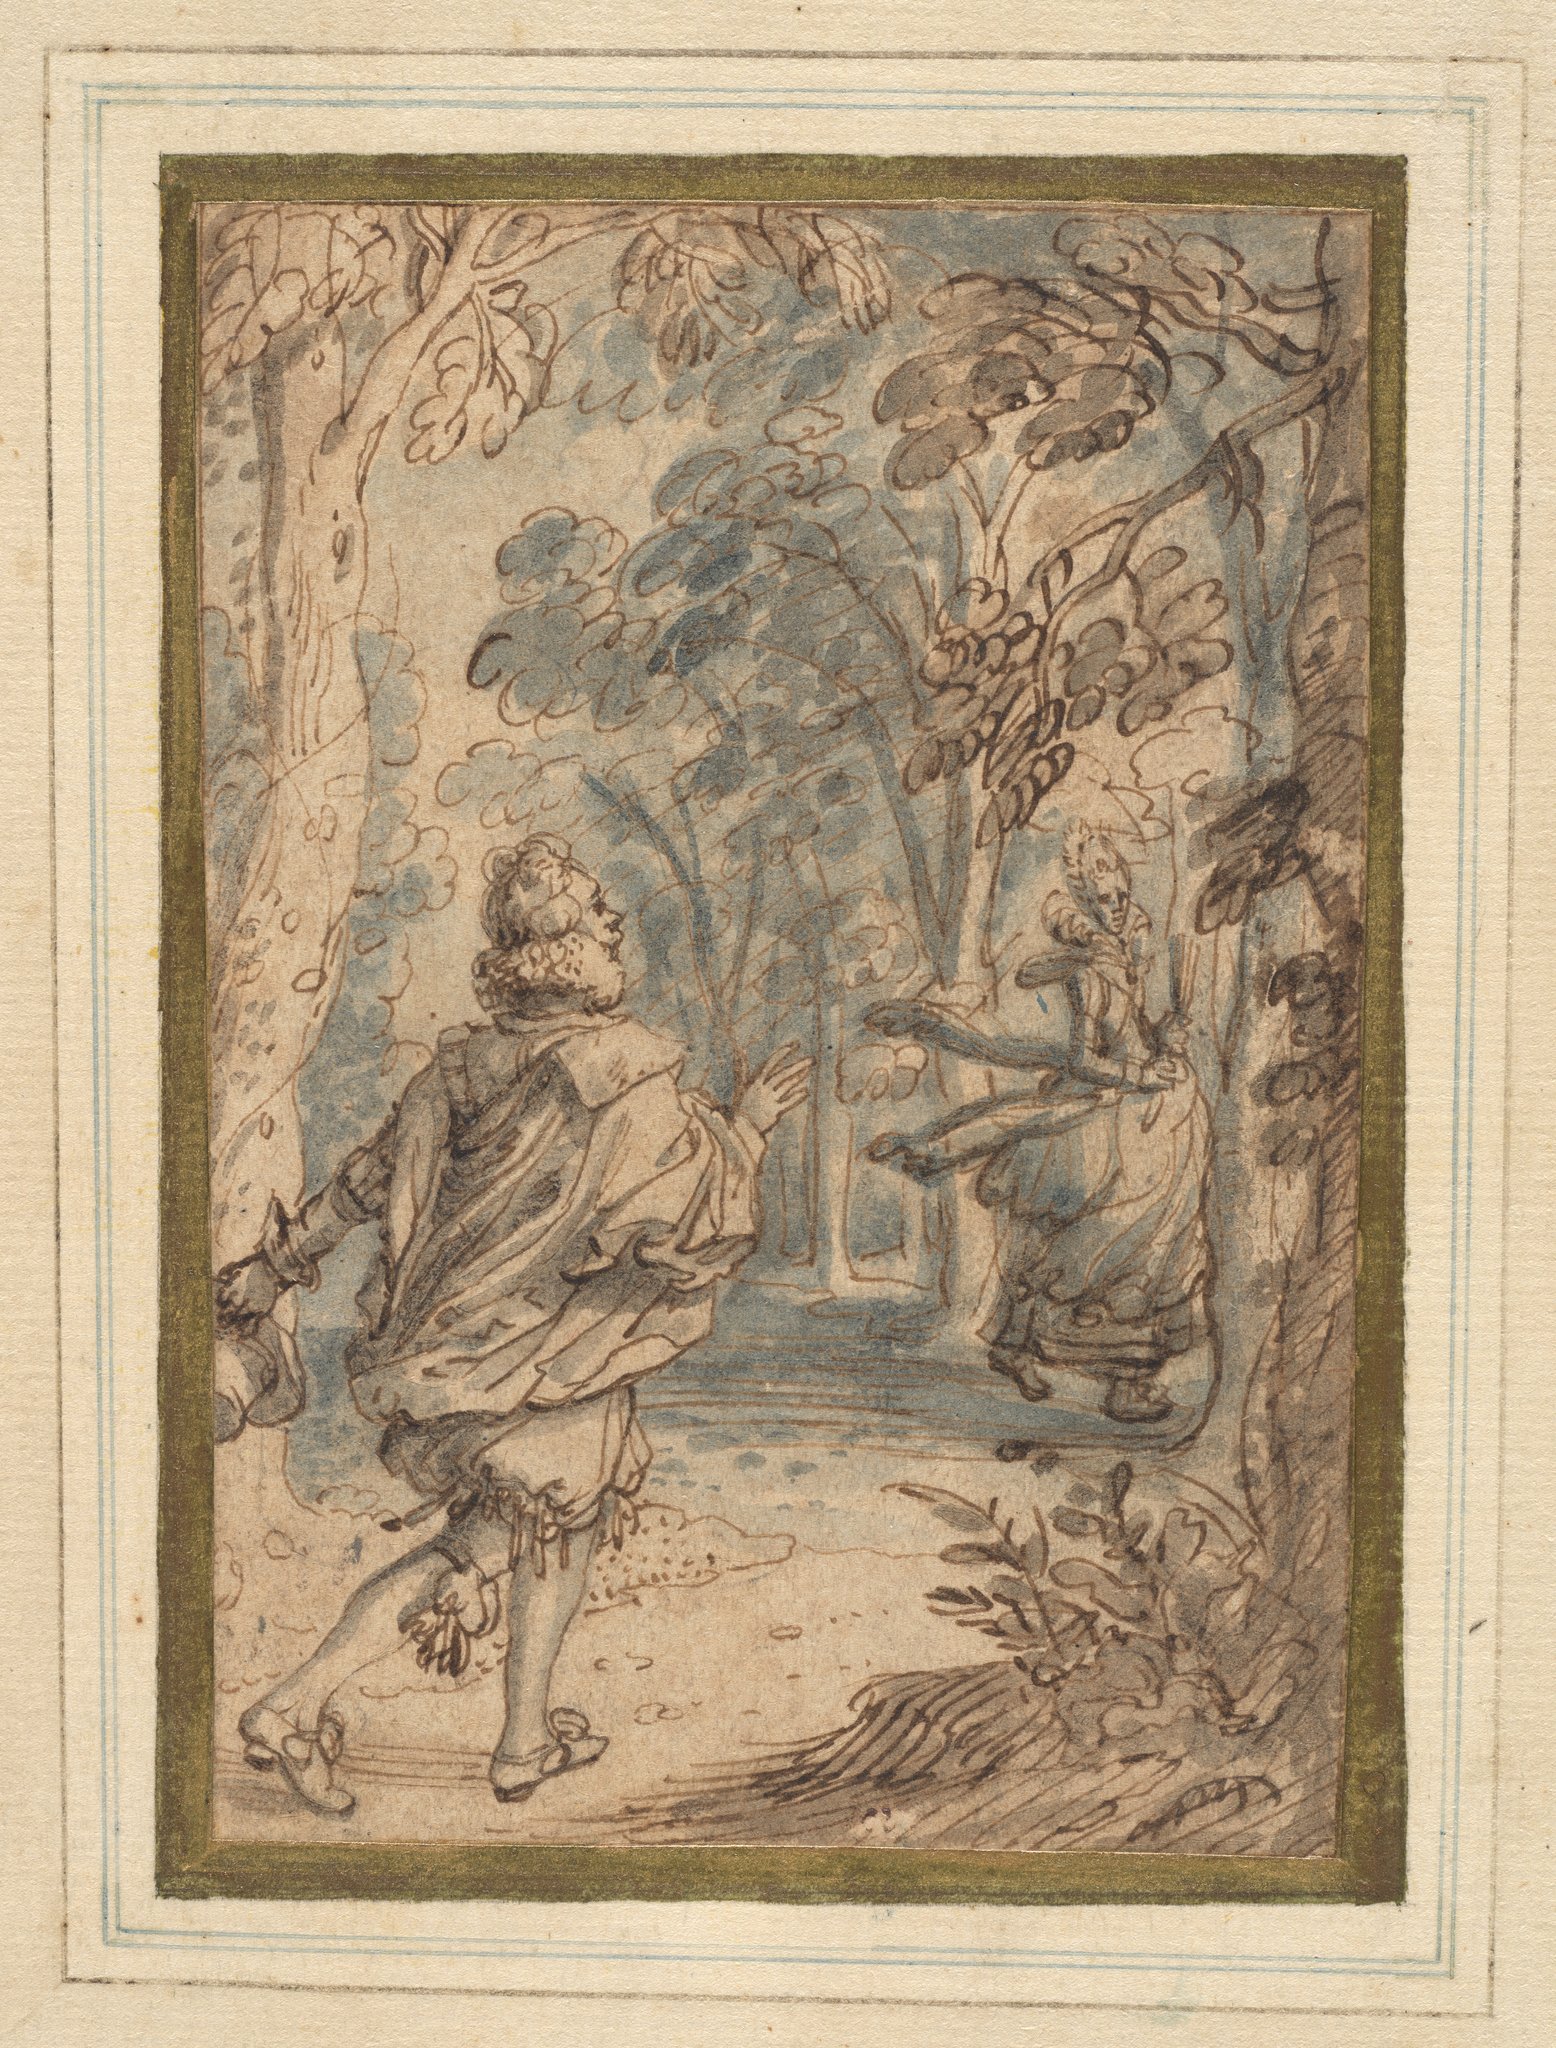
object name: drawing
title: A Young Man Pursuing His Beloved into the Woods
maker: david vinckboons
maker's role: artist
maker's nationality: netherlandish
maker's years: 1576-1629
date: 1621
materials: ink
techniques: pen, wash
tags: men,women,forests